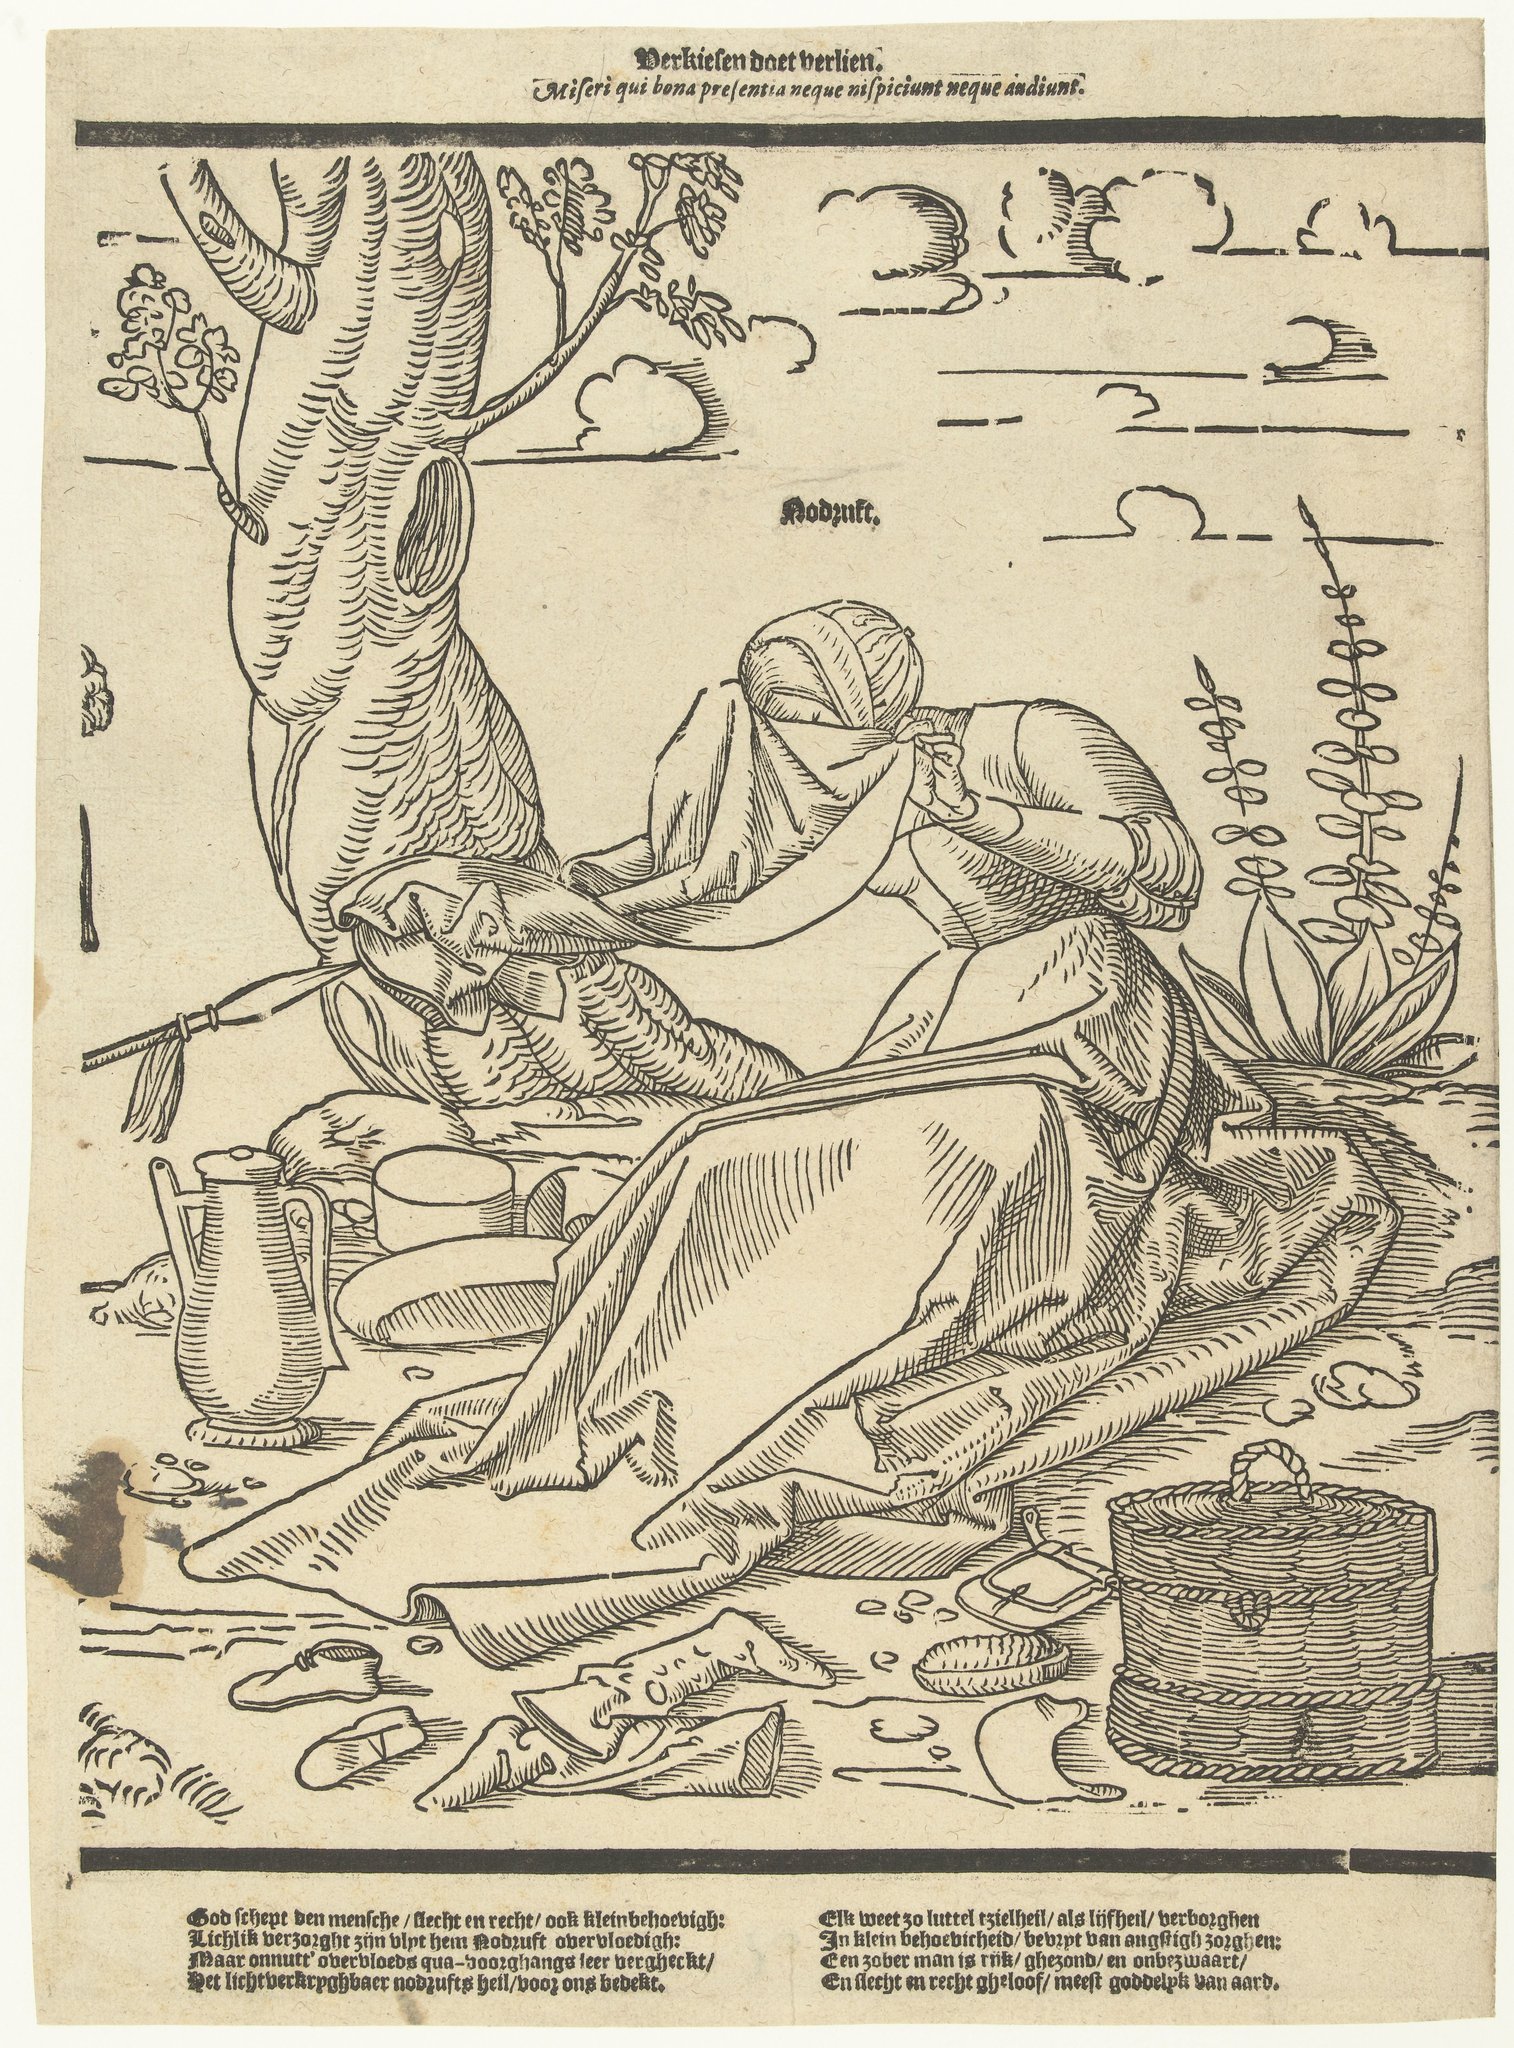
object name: print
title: Verderf-traps beeld-schrift ofte heiligh letteren dat is. Hieroglifica.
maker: Anonymous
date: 1520-1560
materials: paper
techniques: woodcut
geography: low countries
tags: proverbs, sayings, etc., weeping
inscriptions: collector's mark: Lugt 2228a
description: Eén van acht moraliserende spreuken. Nooddruft zittend op de grond, huilend, veegt haar gezicht af aan een doek. Verschillende attributen liggen om haar heen. Tekst onder prent.